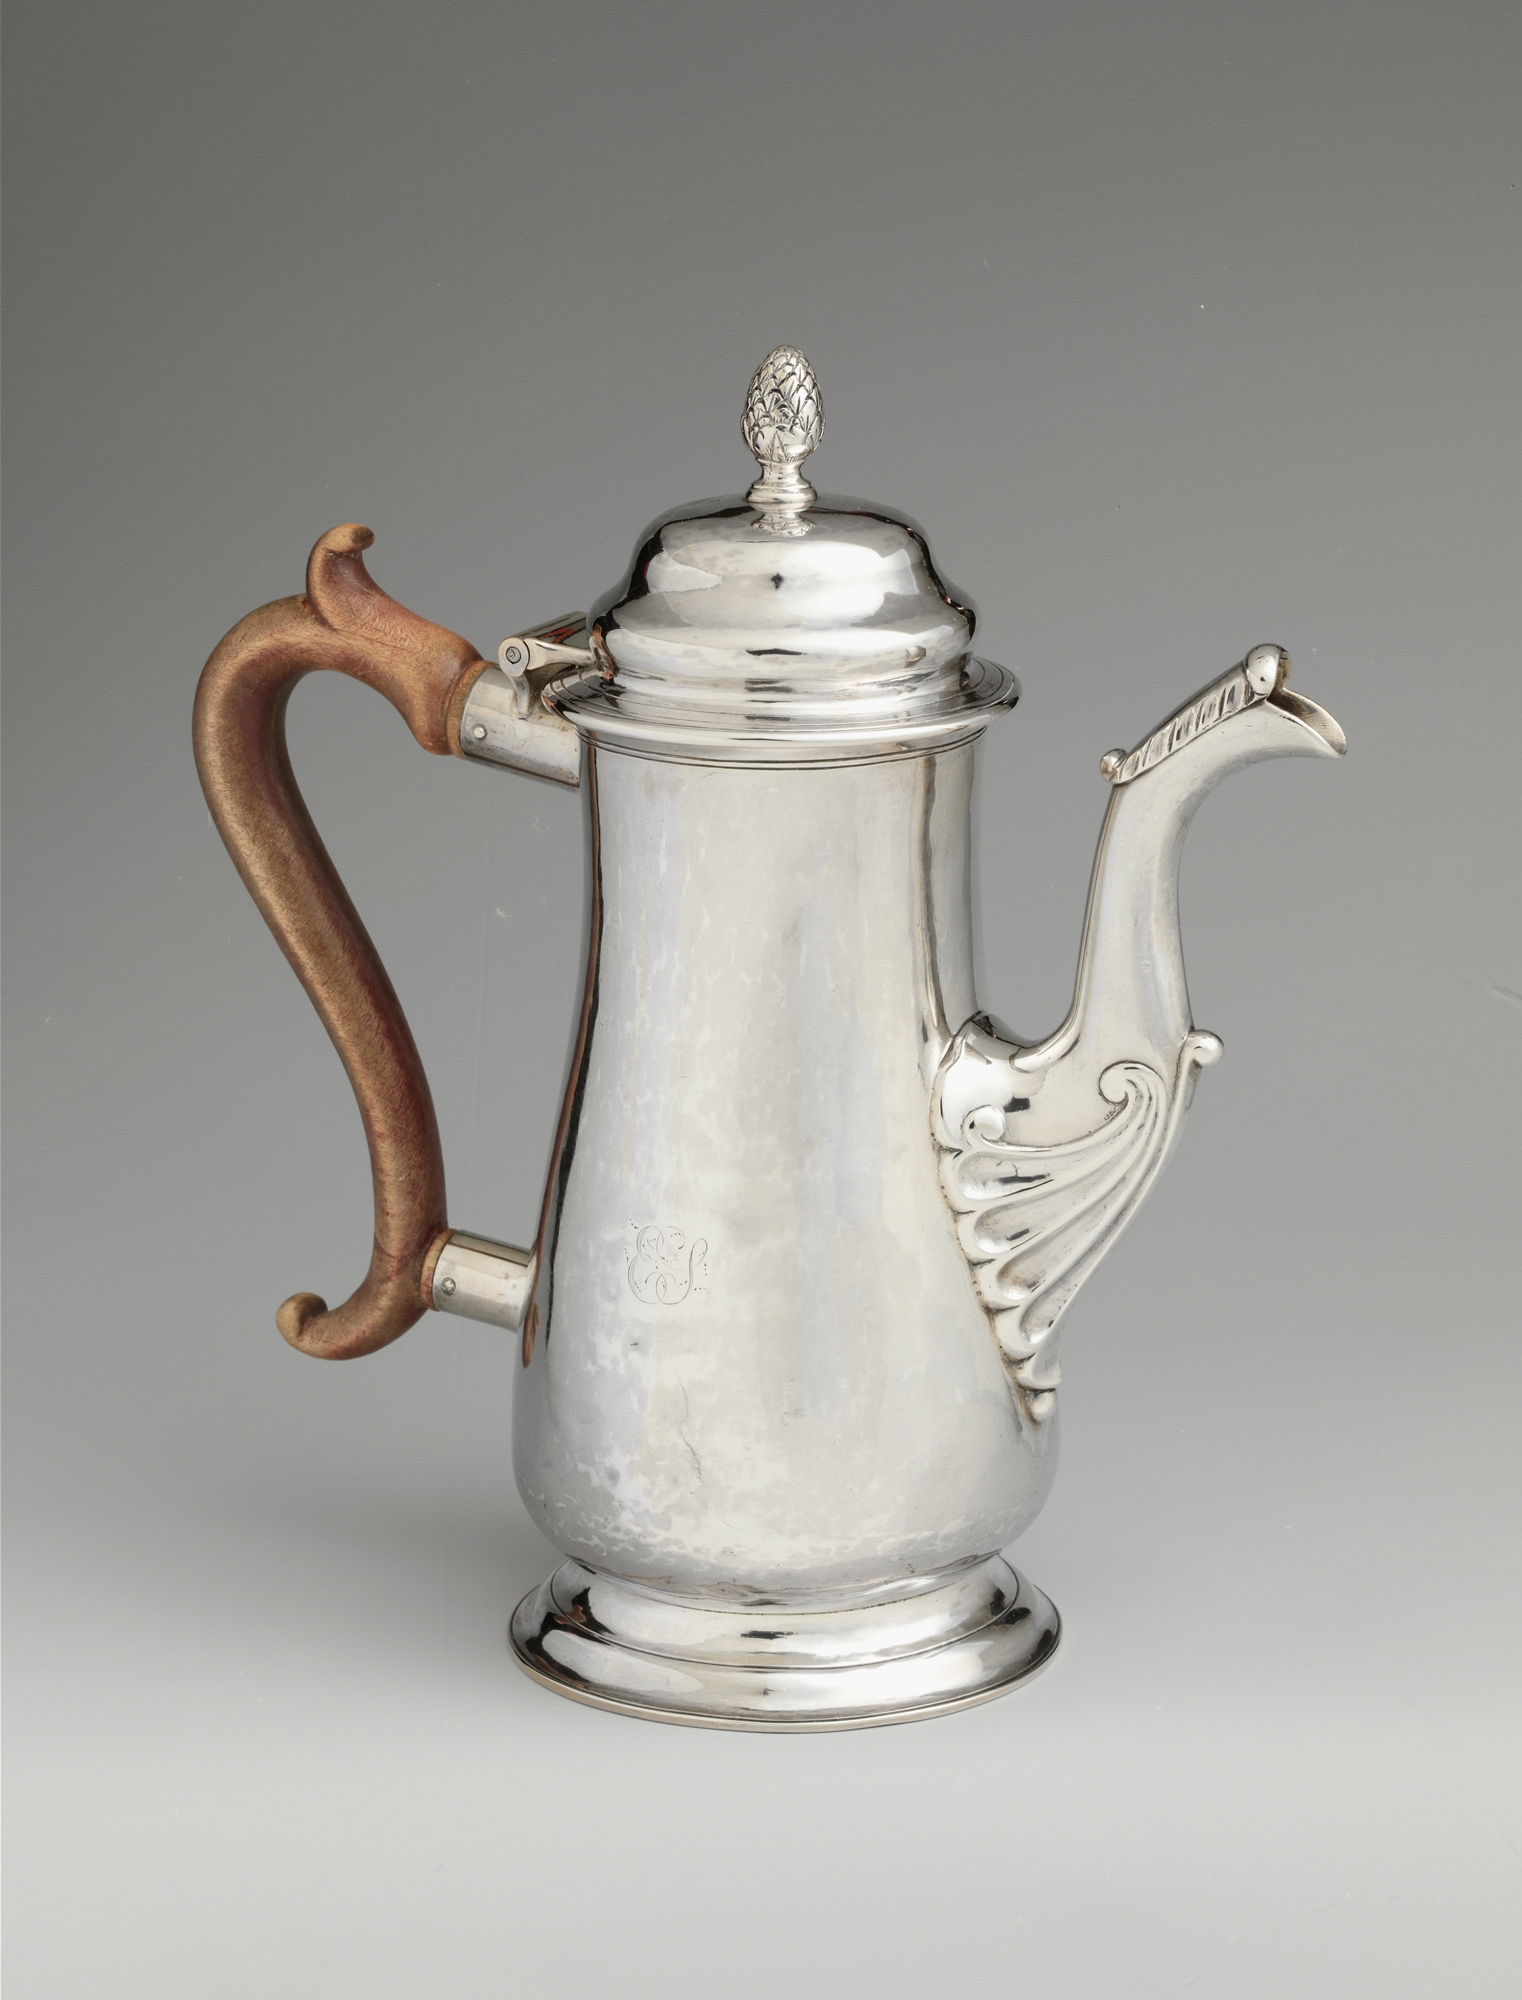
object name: coffeepot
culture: american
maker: samuel edwards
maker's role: maker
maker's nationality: american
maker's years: 1705-1762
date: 1745-1760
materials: silver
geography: united states